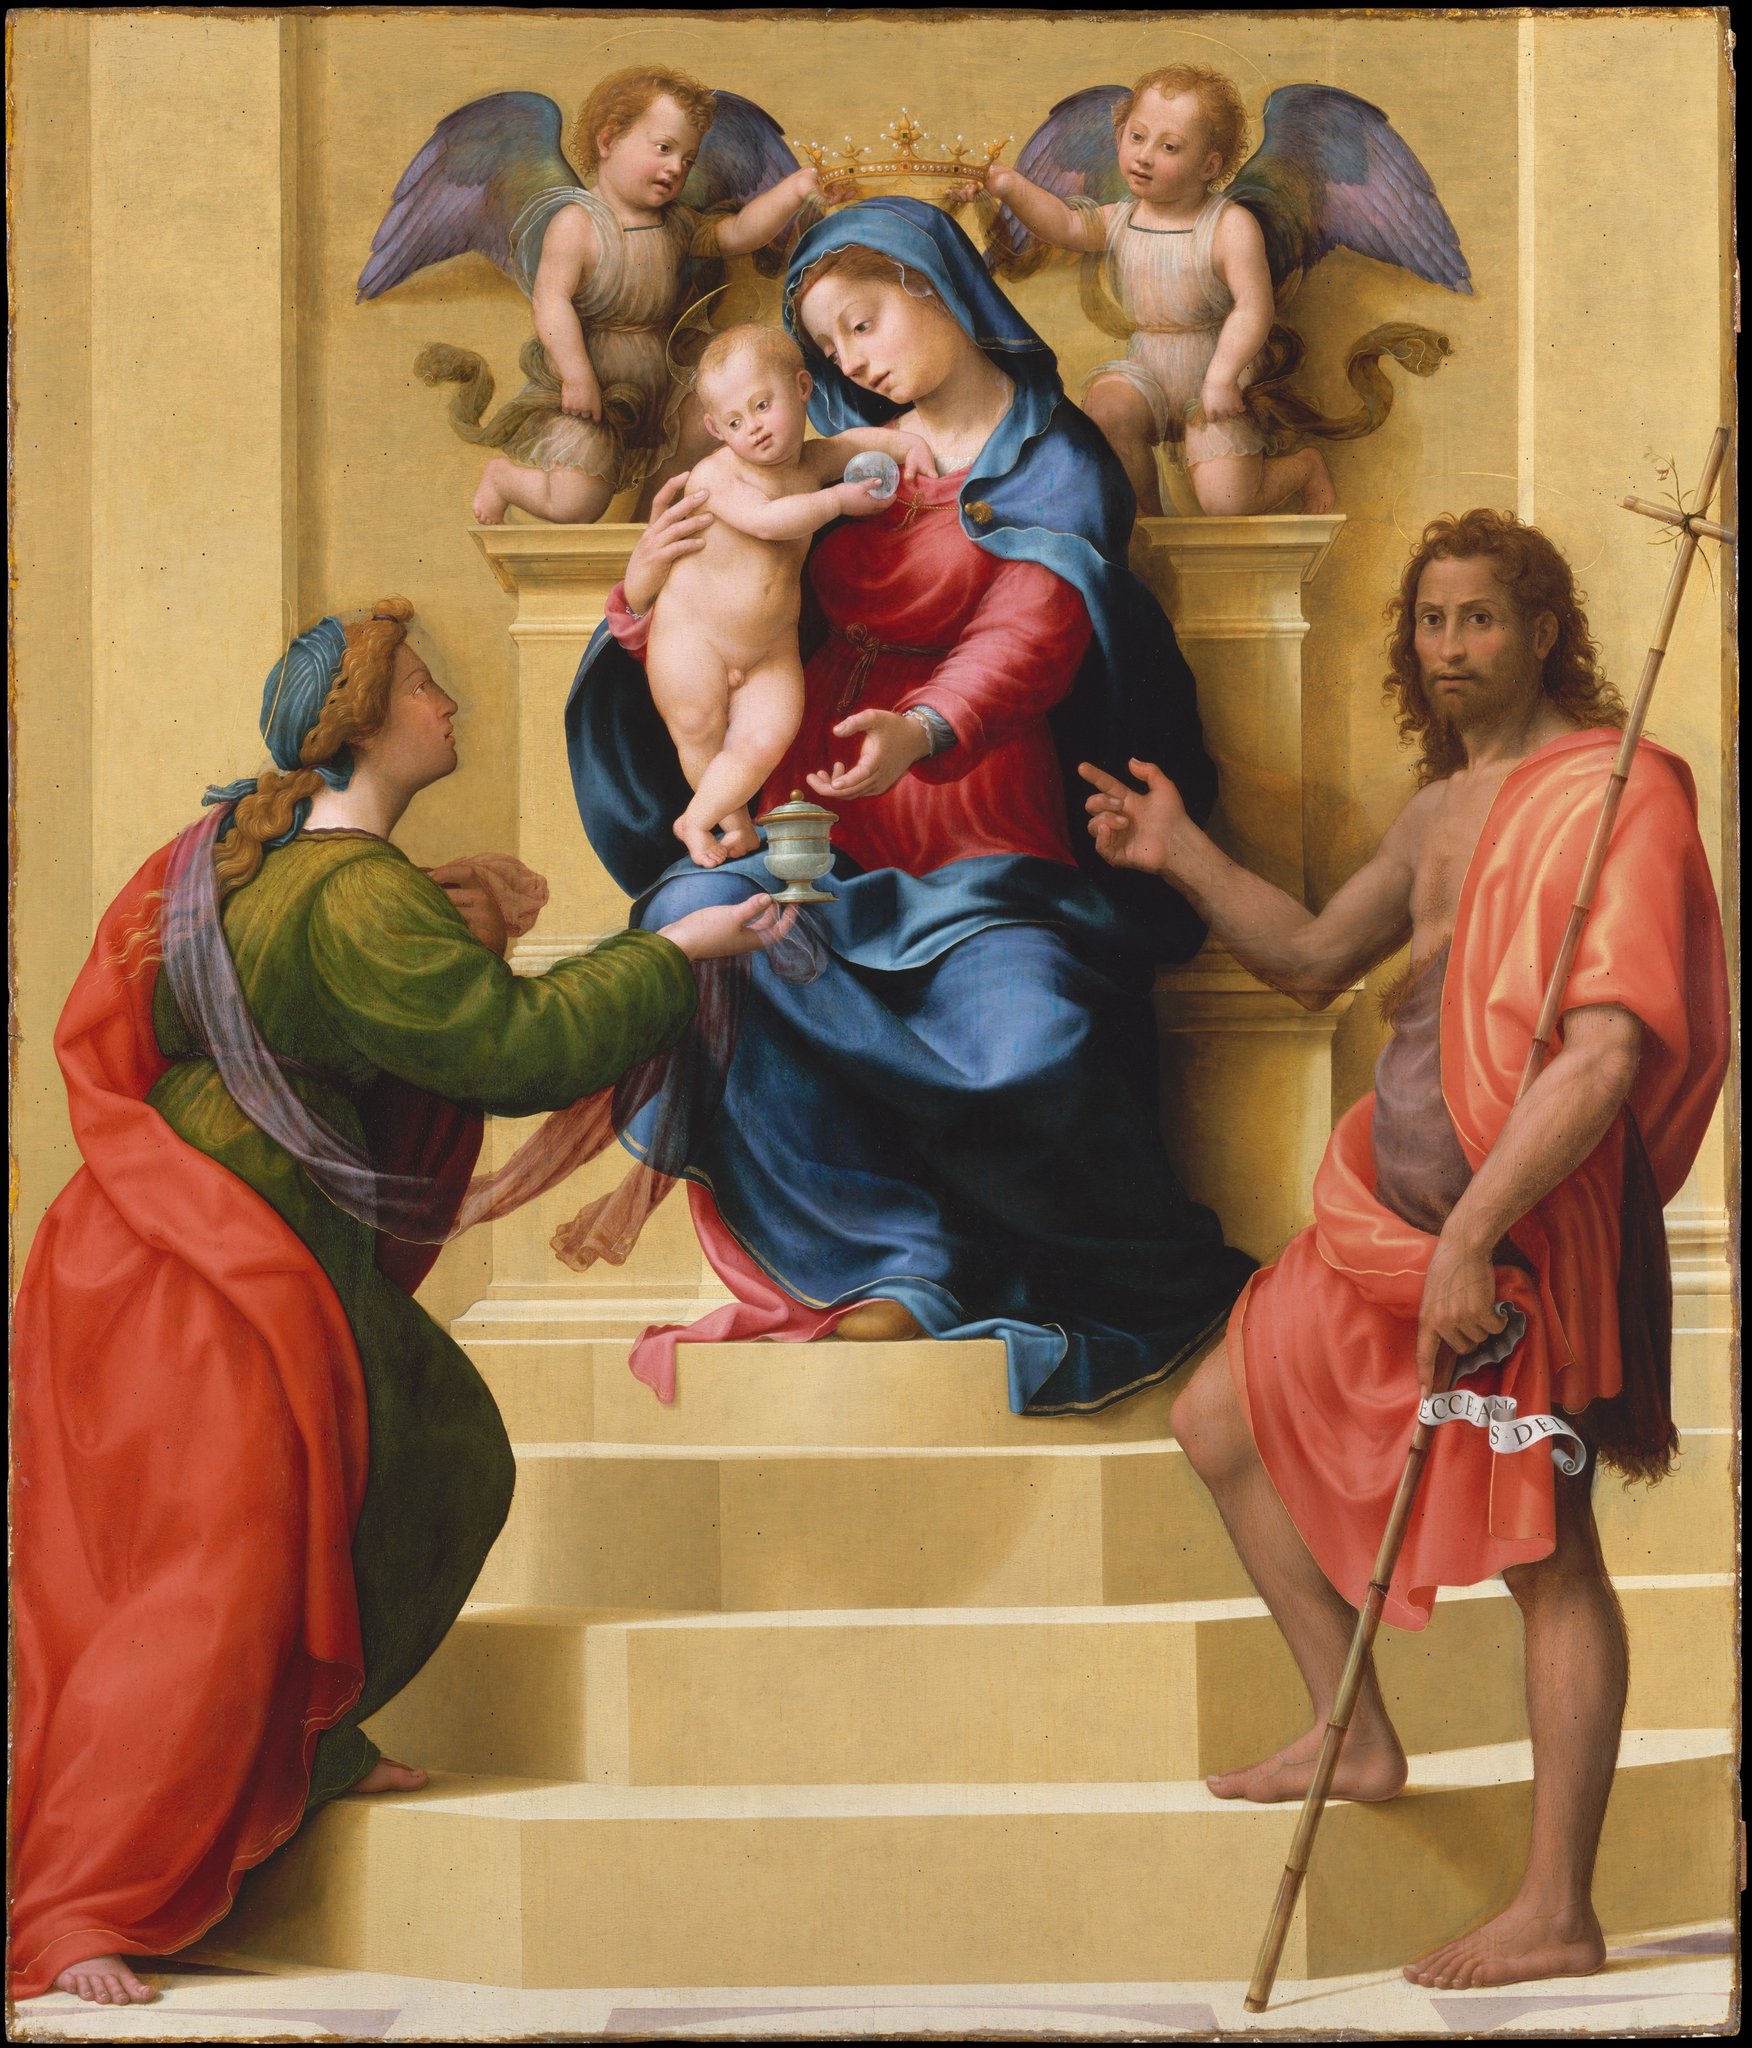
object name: painting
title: Madonna and Child Enthroned with Saints Mary Magdalen and John the Baptist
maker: giuliano di piero di simone bugiardini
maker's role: artist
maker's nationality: italian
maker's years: 1475-1554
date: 1523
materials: oil, wood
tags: angels,madonna and child,mary magdalene,saint john the baptist